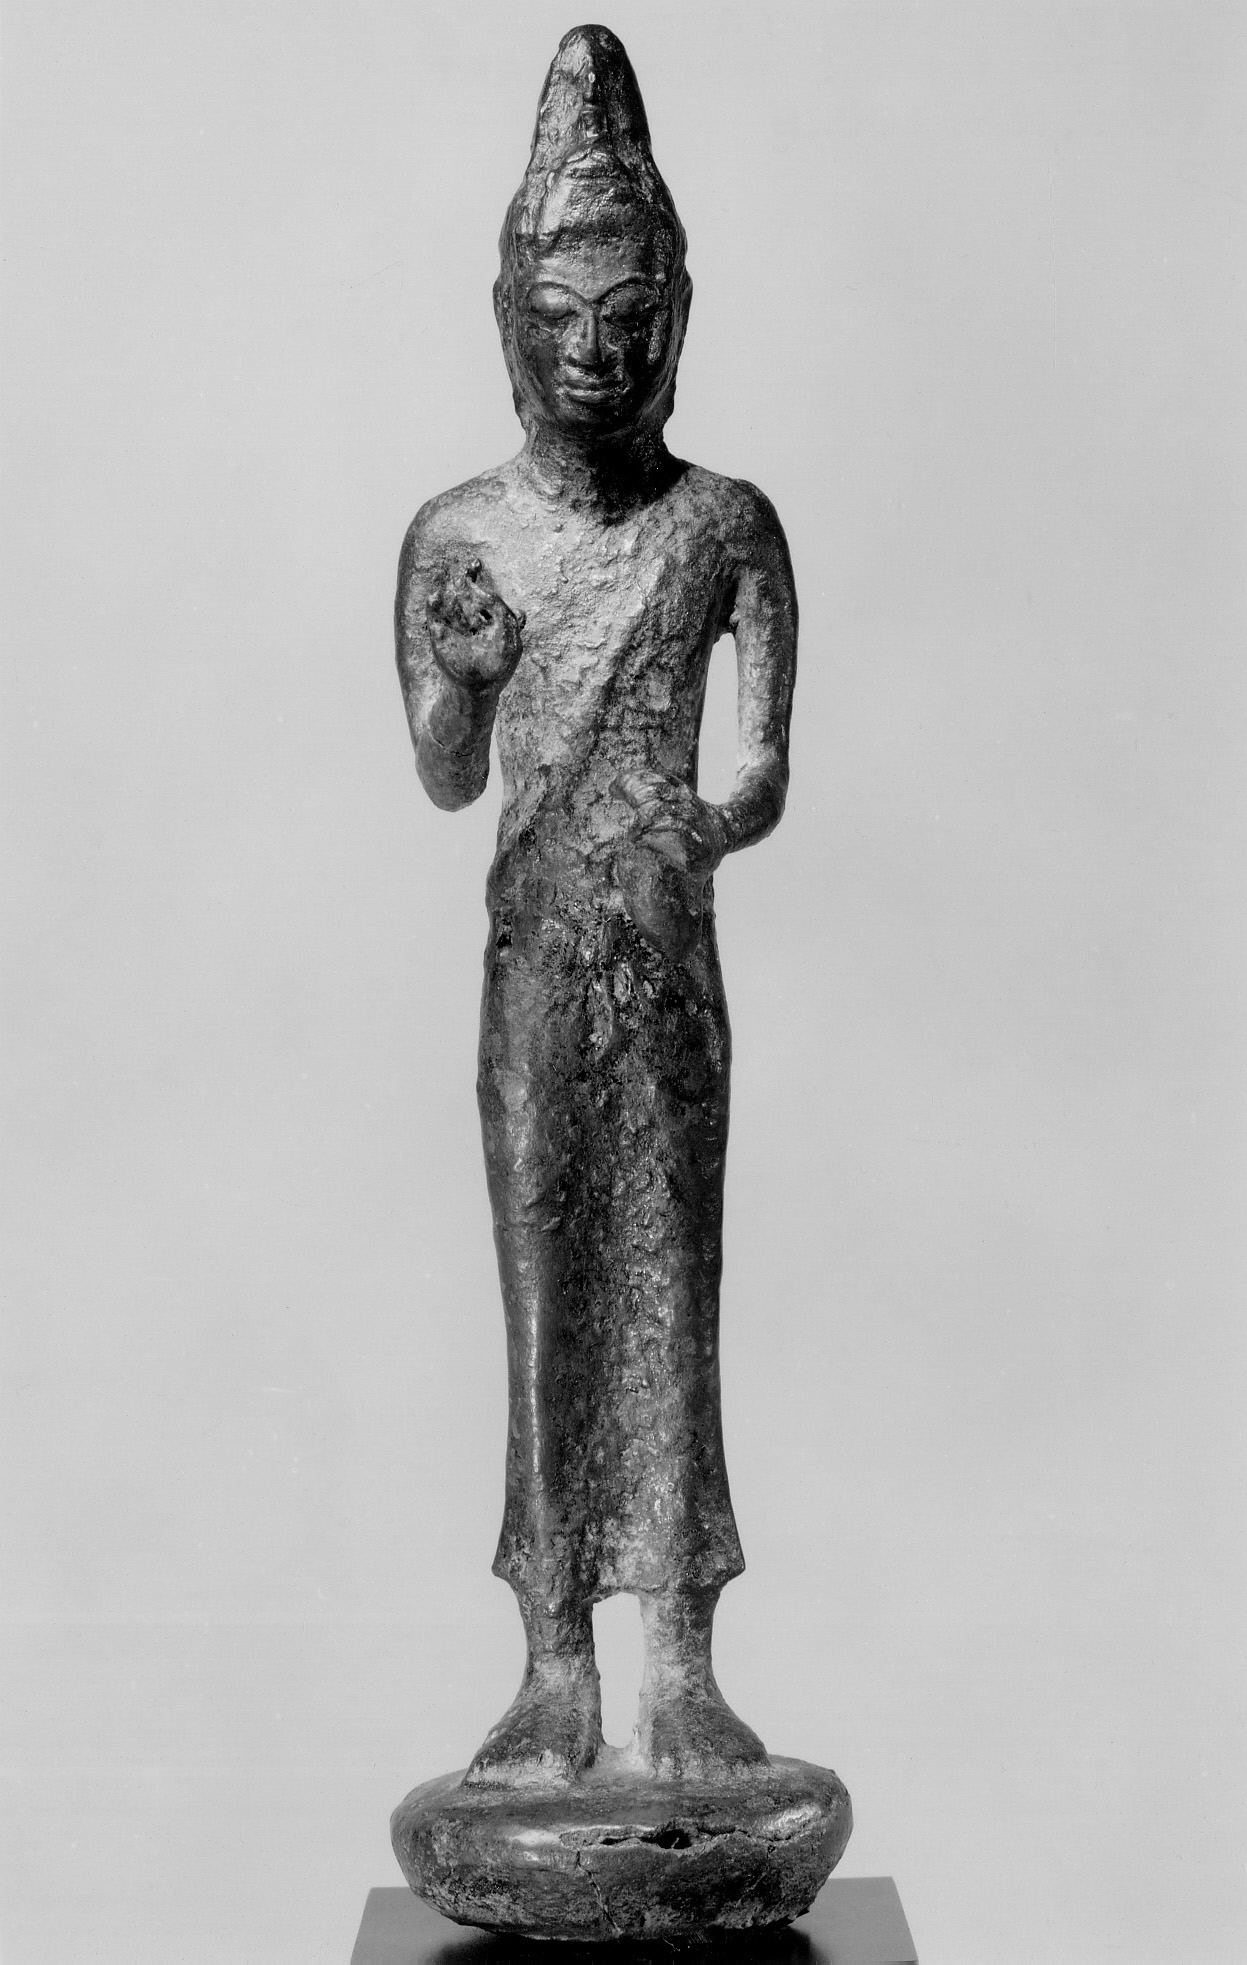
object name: figure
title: Standing Avalokiteshvara (the Bodhisattva of Infinite Compassion)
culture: thai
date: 701-800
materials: bronze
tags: buddhism,avalokiteshvara,bodhisattvas